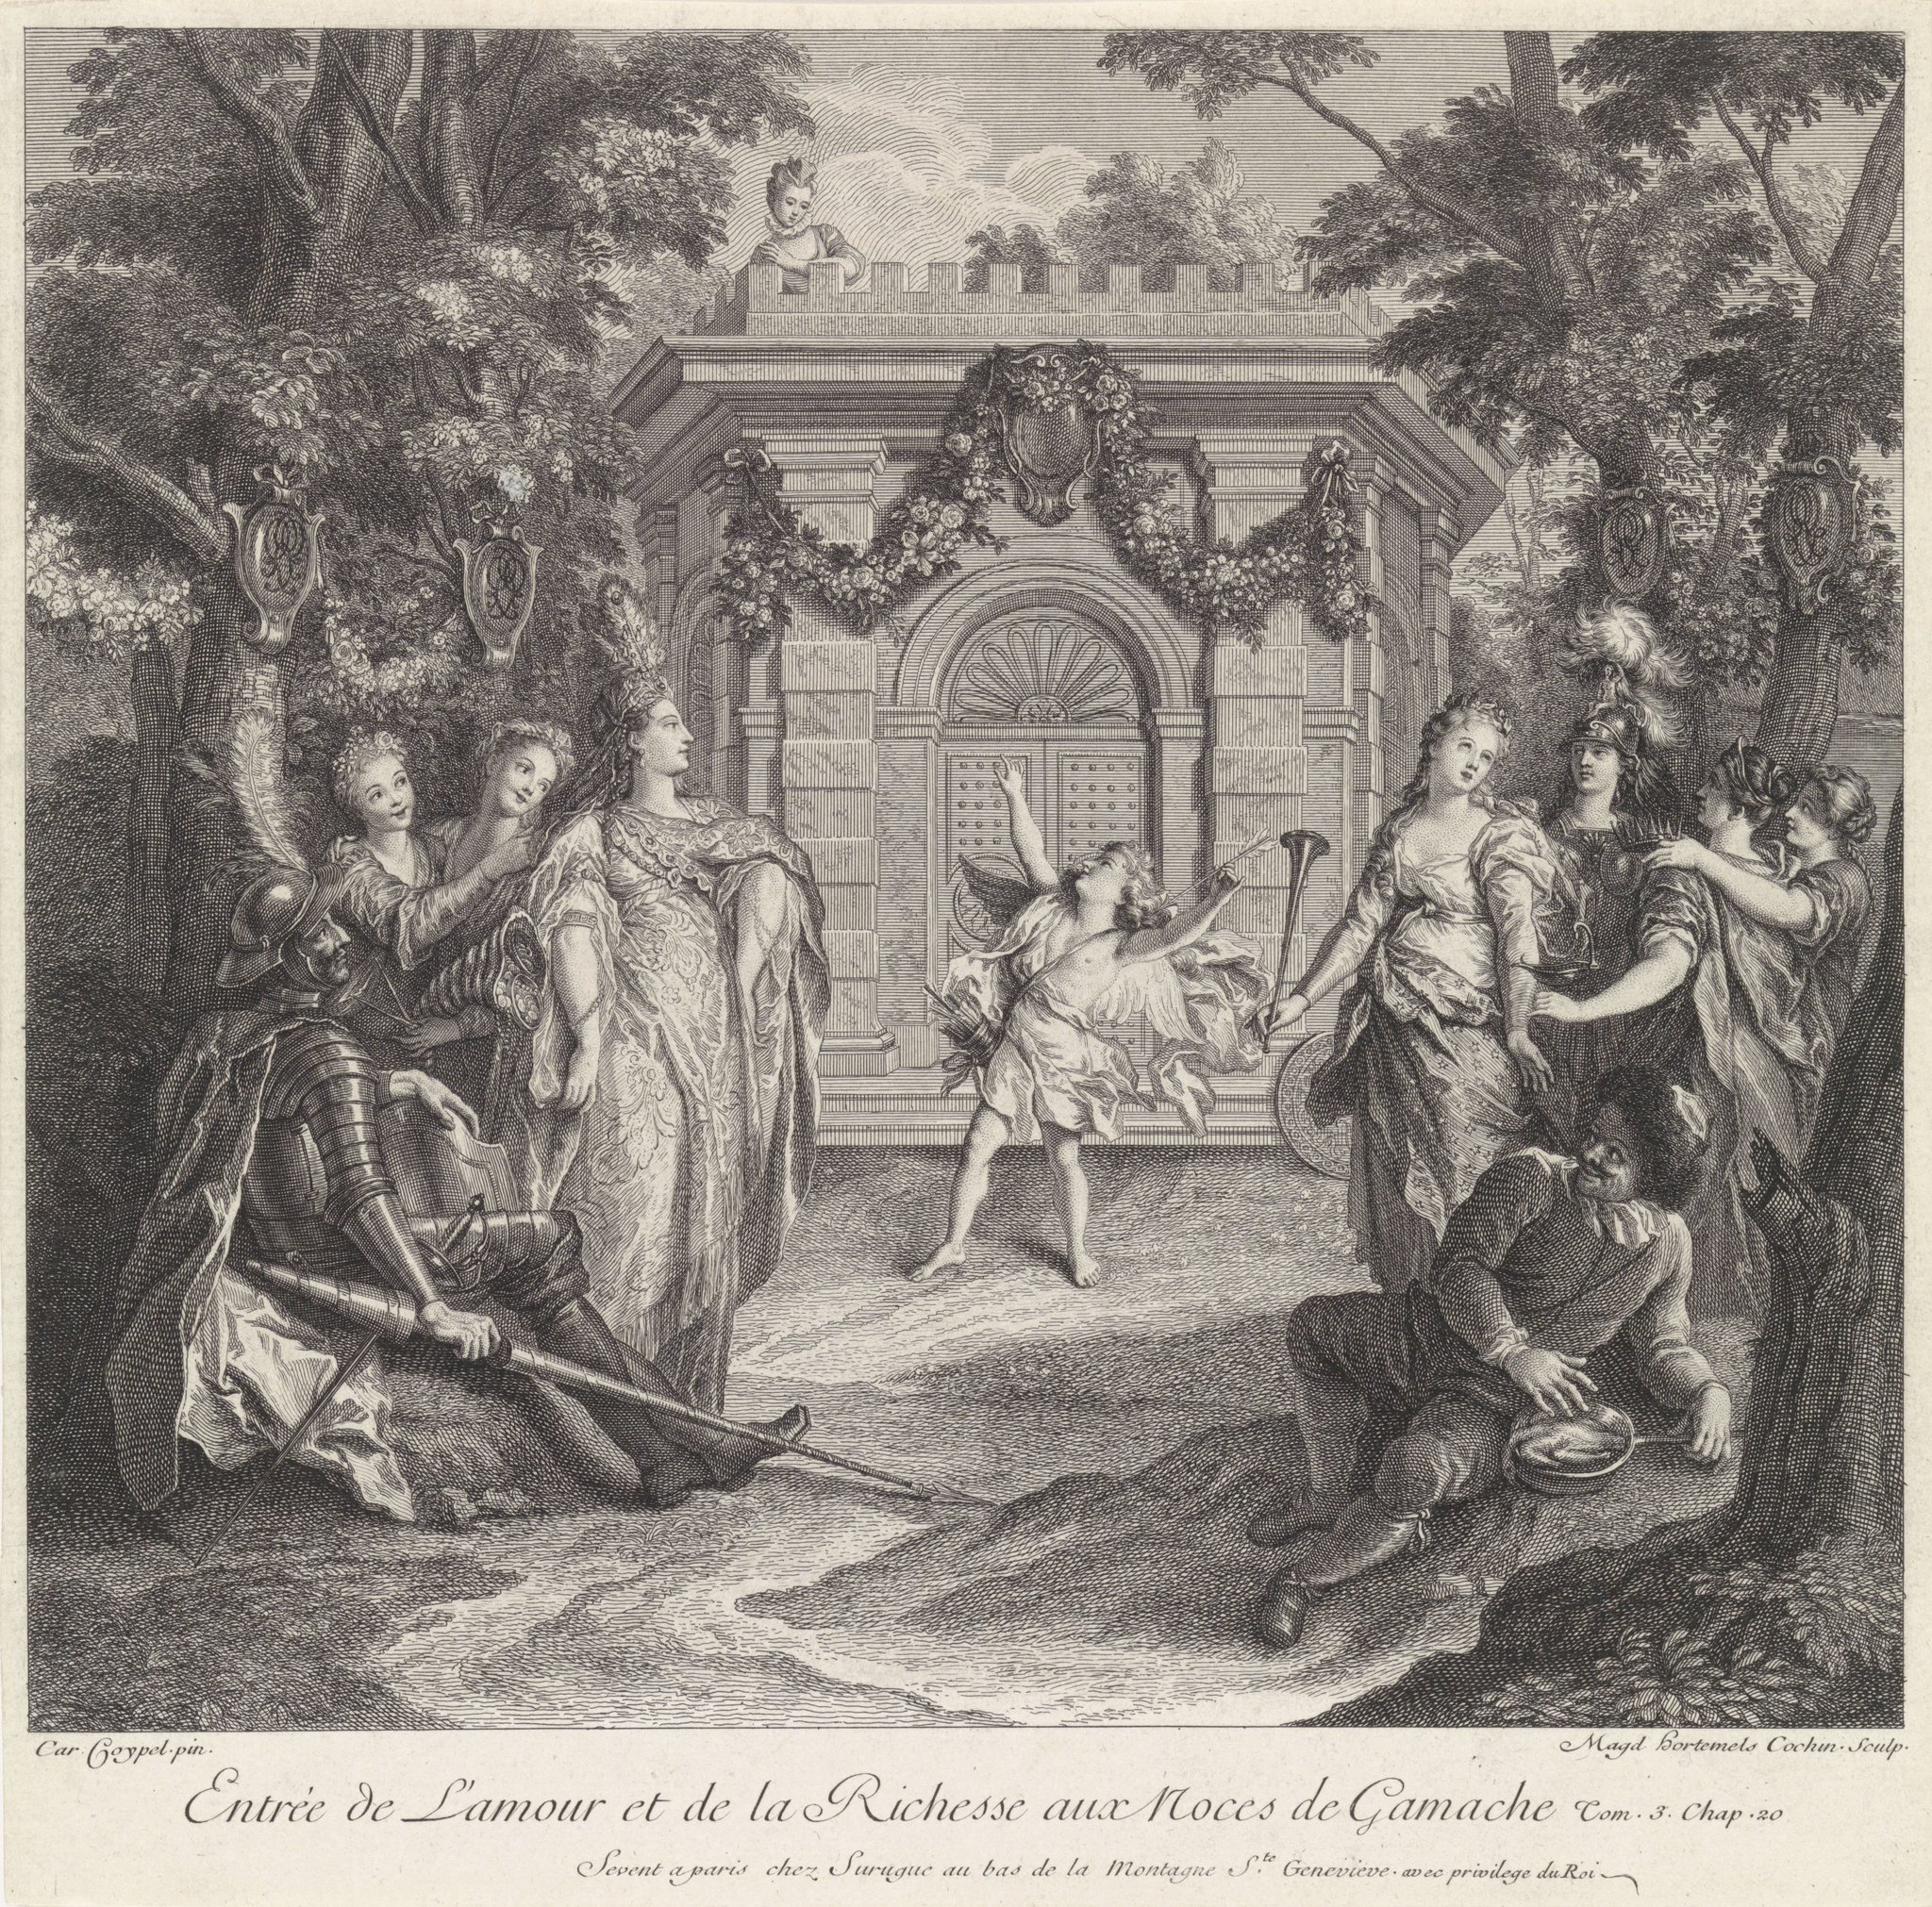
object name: print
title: Toneelopvoering op de bruiloft van Gamache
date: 1714-1762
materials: paper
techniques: engraving, etching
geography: paris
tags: theatre, theatrical performance, literary characters and objects, (story of) cupid, amor (eros), property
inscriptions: collector's mark: Lugt 240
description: Een figuur verkleed als Amor en een vrouw verkleed als de personificatie van rijkdom in een boomrijk landschap. Linksvoor zit Don Quichot en links Sancho Panca, met een kip in een pan. Scène uit het verhaal van Don Quichot van La Mancha. Onderaan gemerkt: hoofdstuk 20.